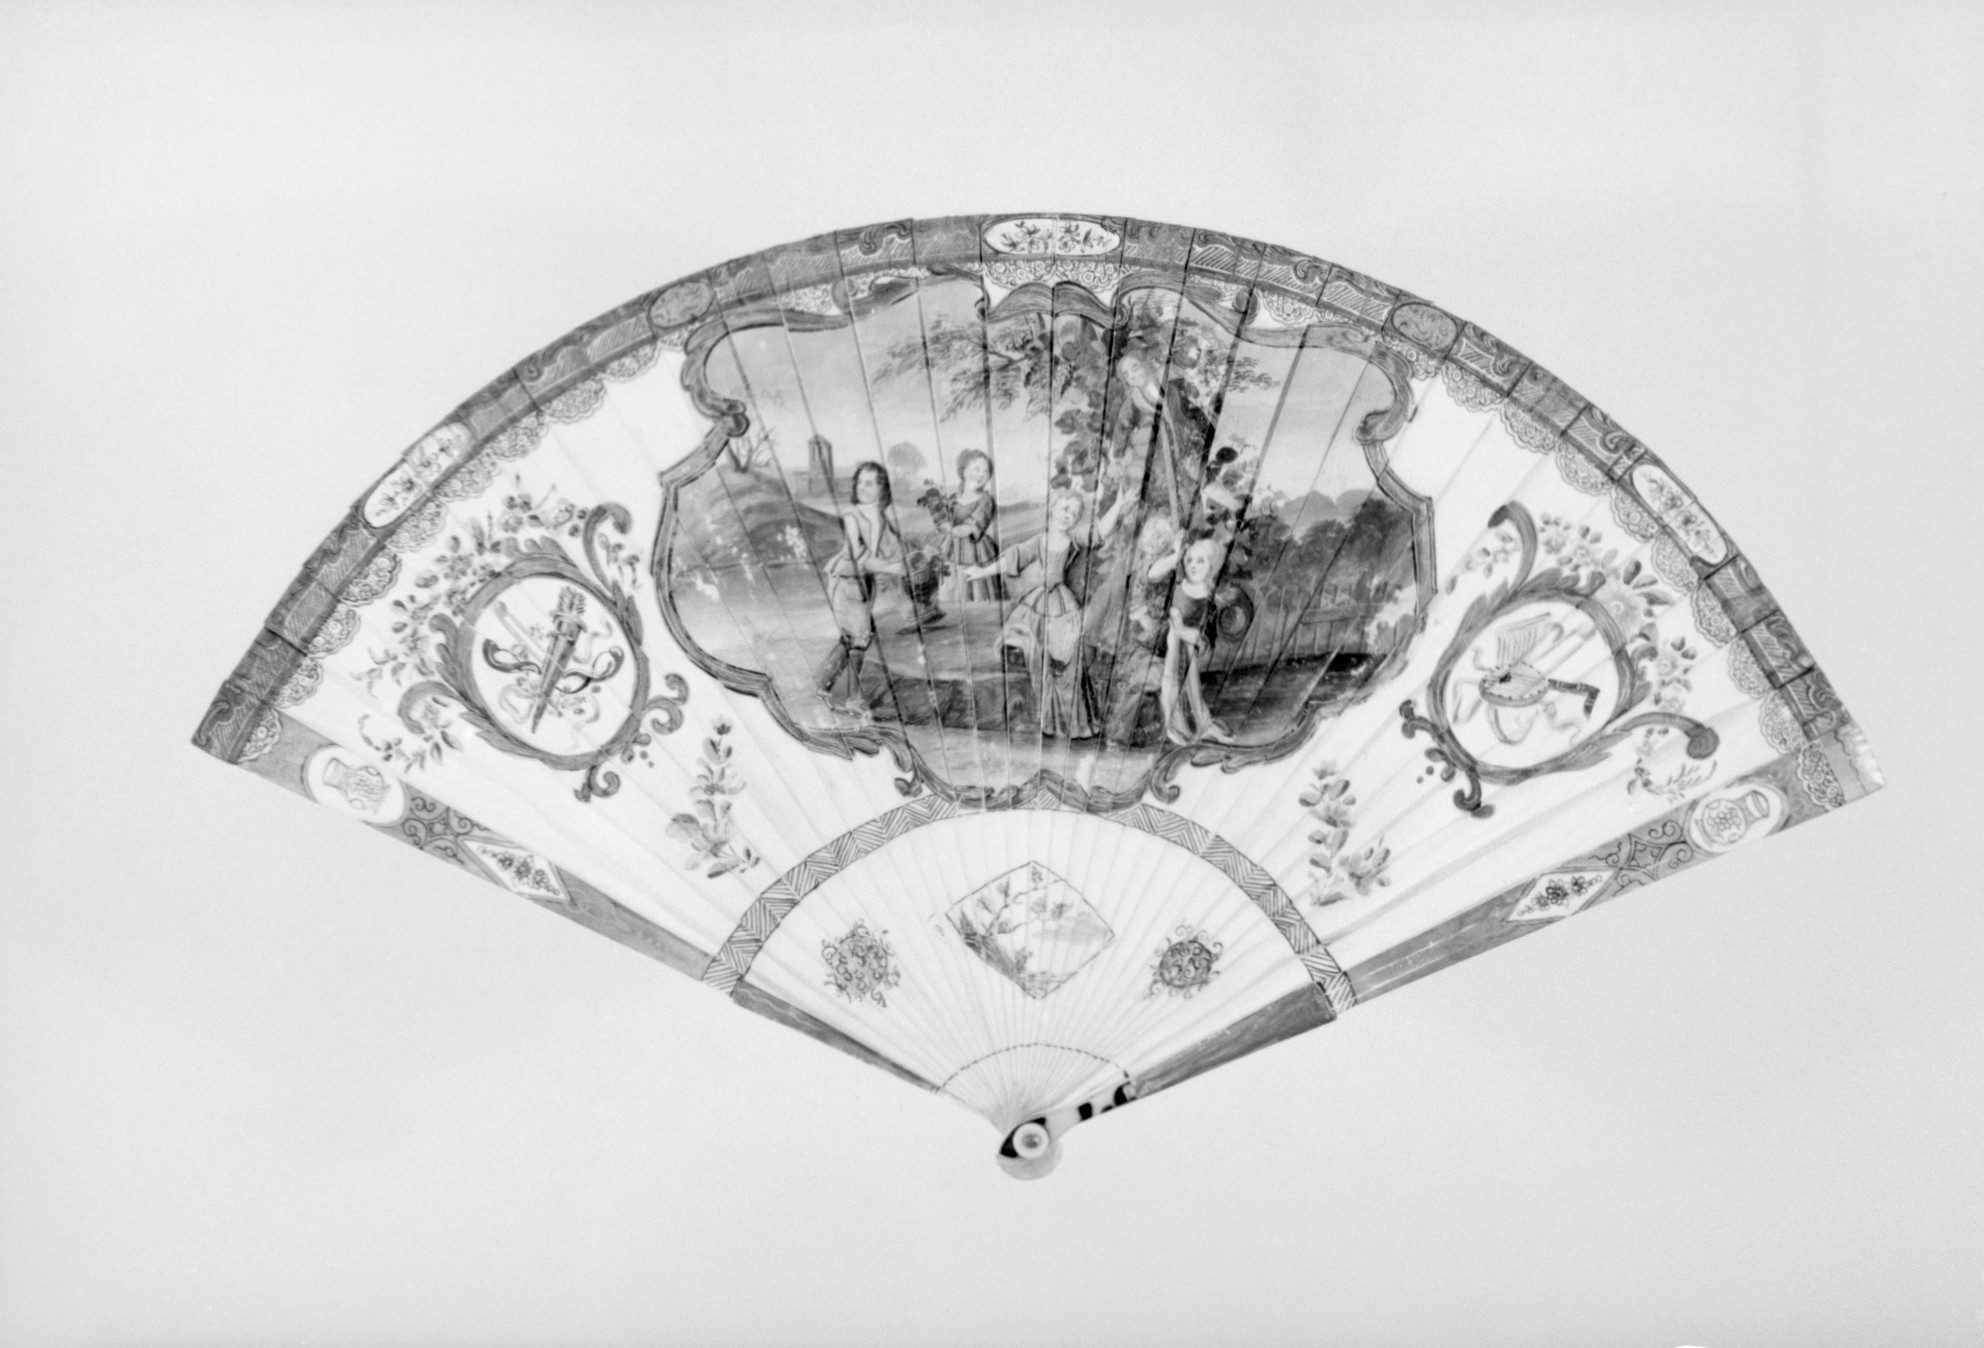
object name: fan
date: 1851-1900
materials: ivory, metal, paint, silk, shell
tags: men,women